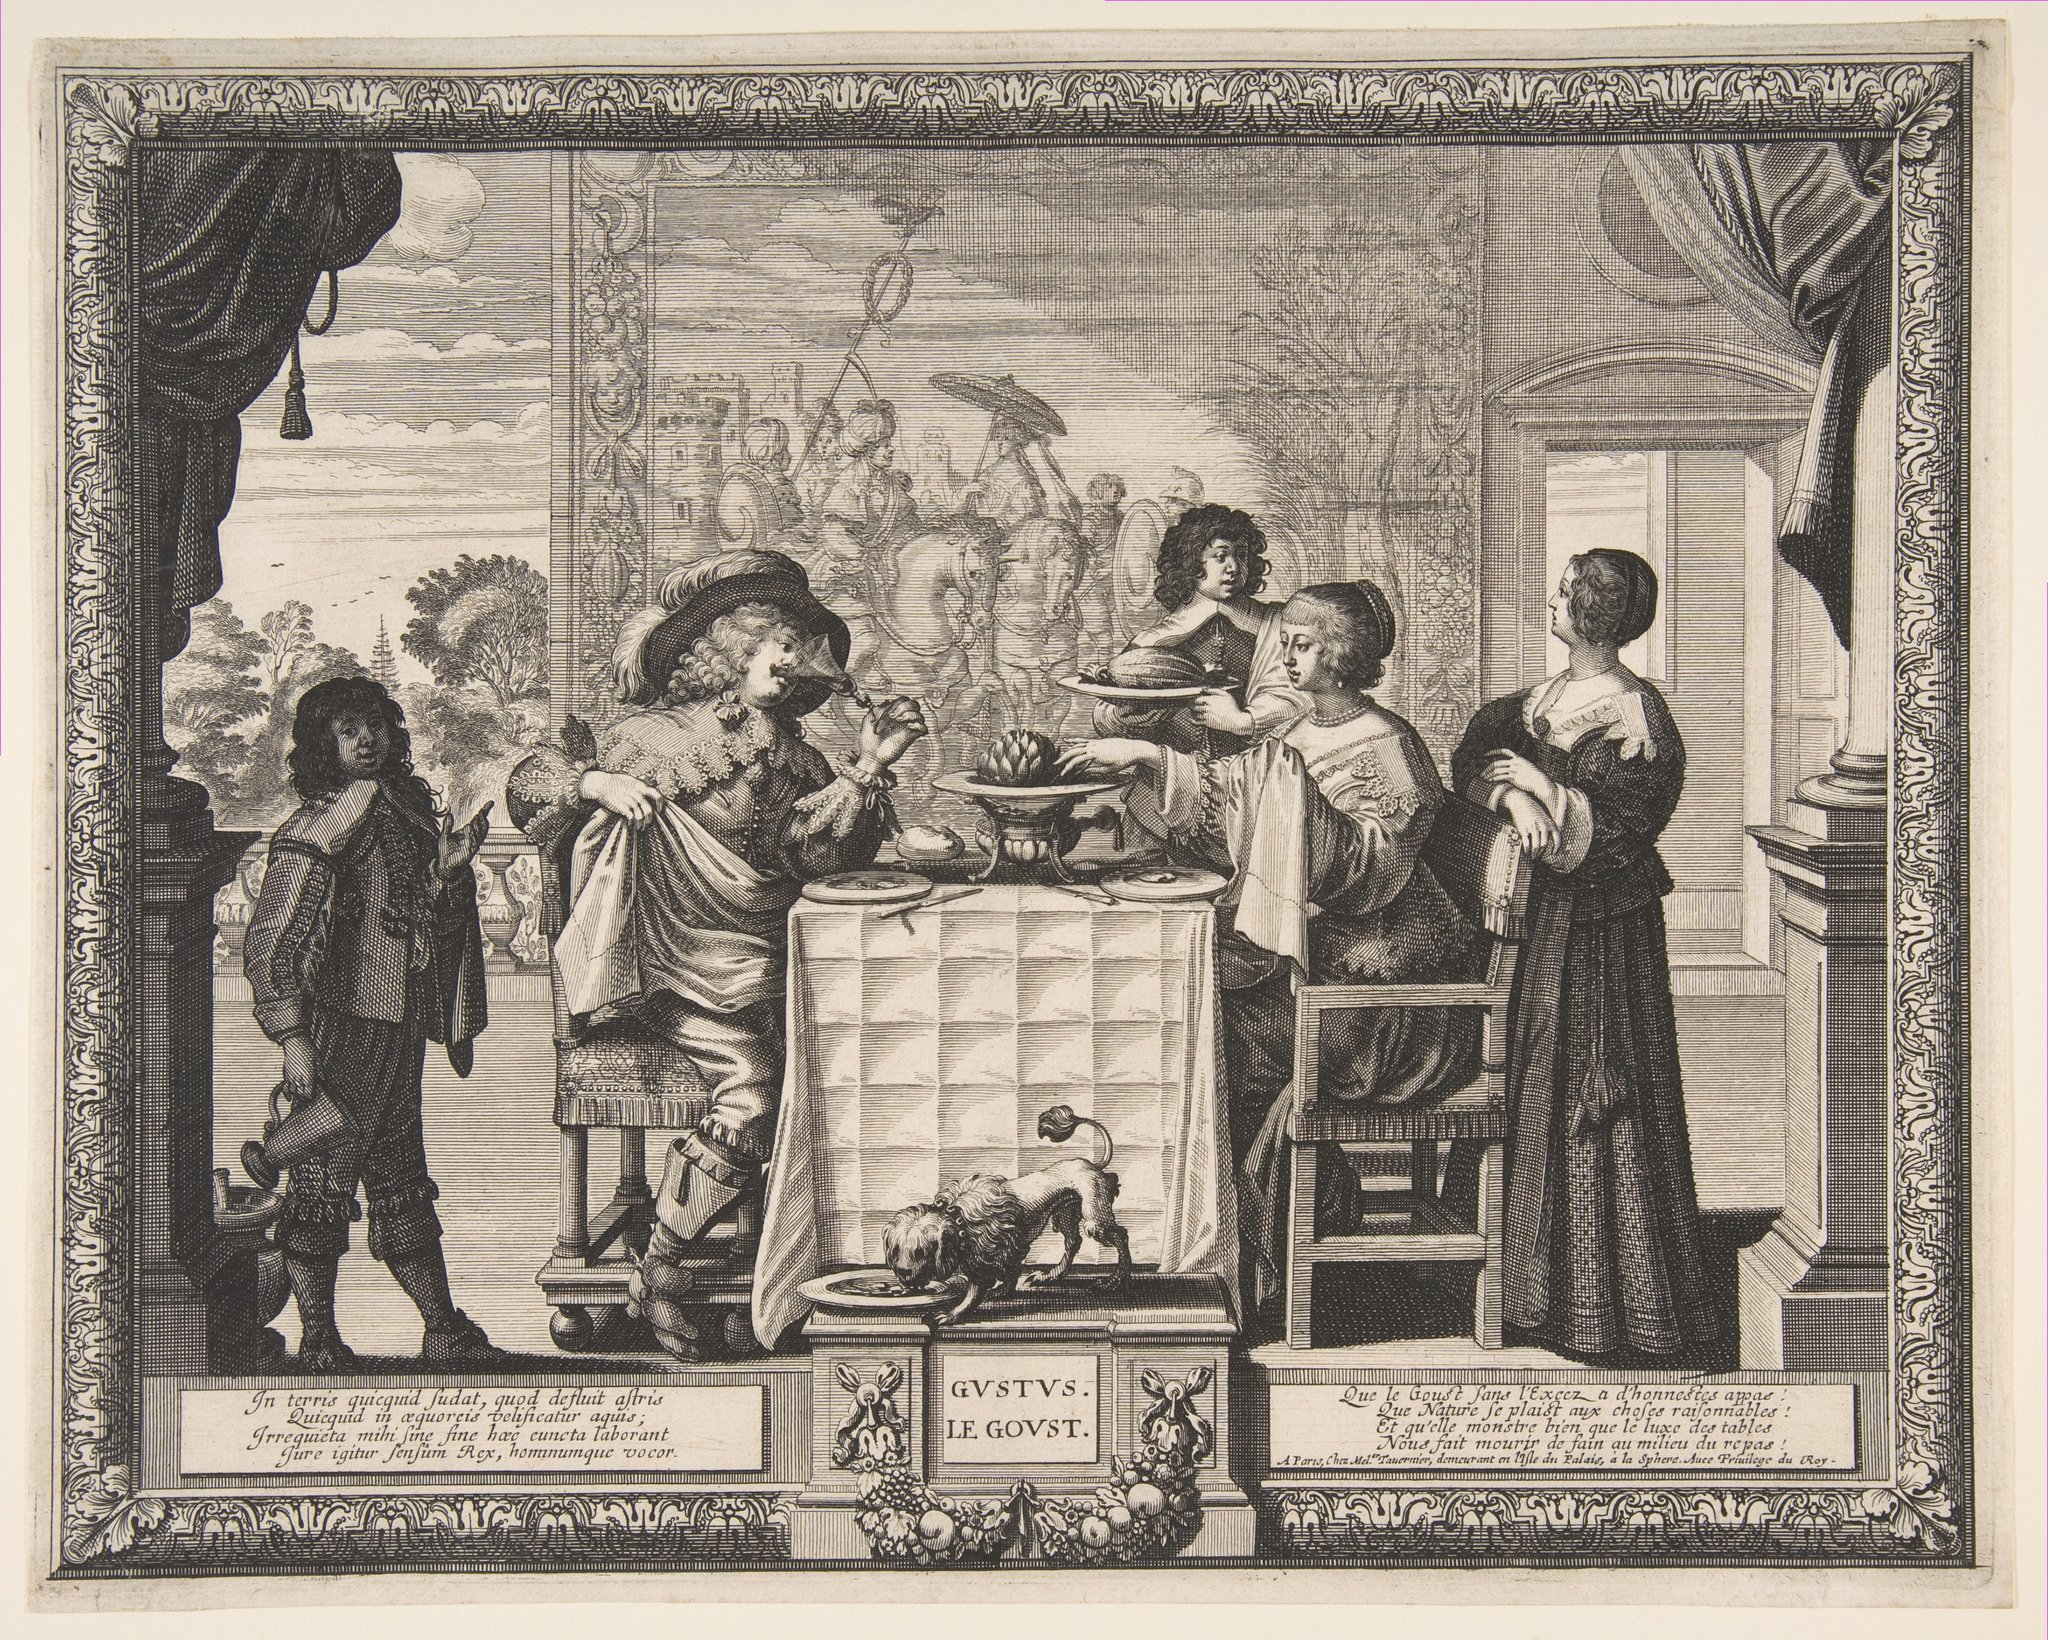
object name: print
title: Taste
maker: abraham bosse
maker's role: artist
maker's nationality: french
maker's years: 1602-1676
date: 1635-1638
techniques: etching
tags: food,men,women,dogs,dining,drinking